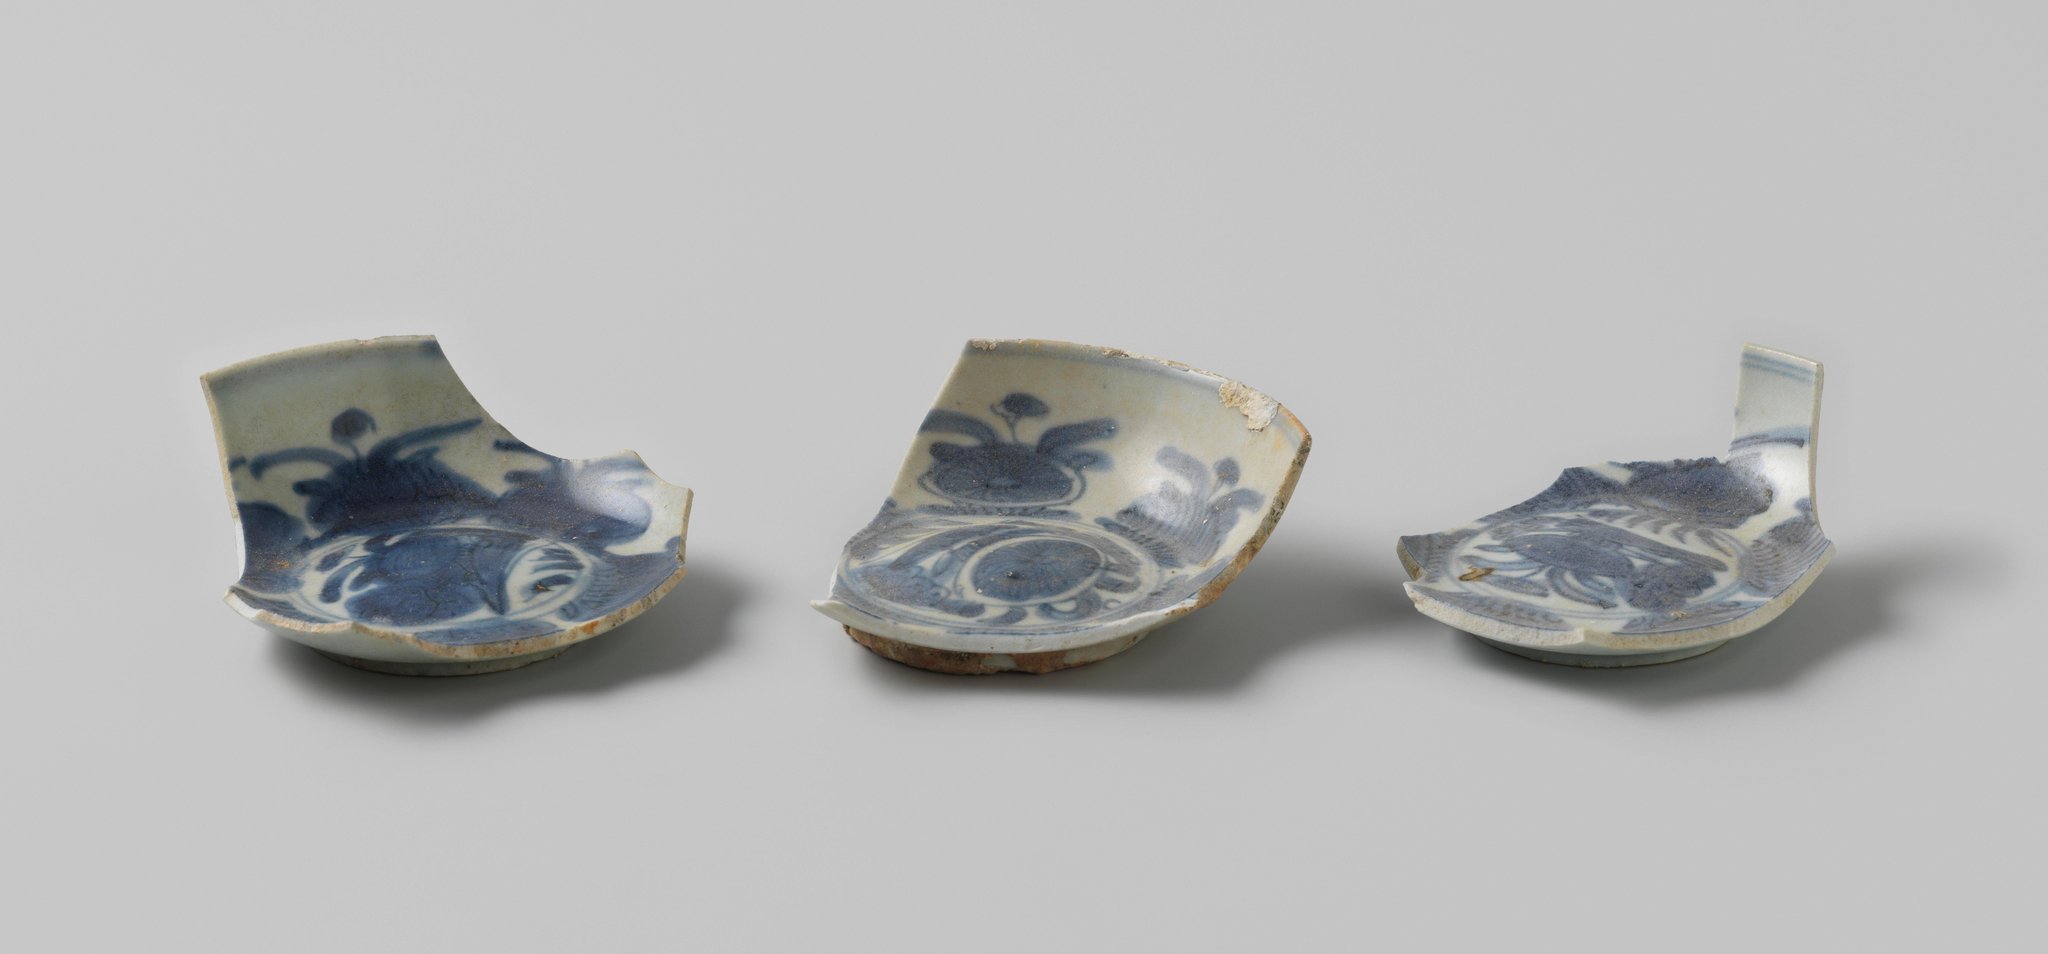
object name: platter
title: Fragmenten van schotels uit V.O.C.-schip de 'Witte Leeuw'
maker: Anonymous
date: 1613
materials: porcelain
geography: jingdezhen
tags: verenigde oostindische compagnie, sint-helena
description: A saucer. The colour of the cobalt blue varies from grey to purple blue. The decoration on the inside consists of a flowering lotus plant with a duck underneath in the centre. On the cavetto 6 similar lotus plants are drawn.